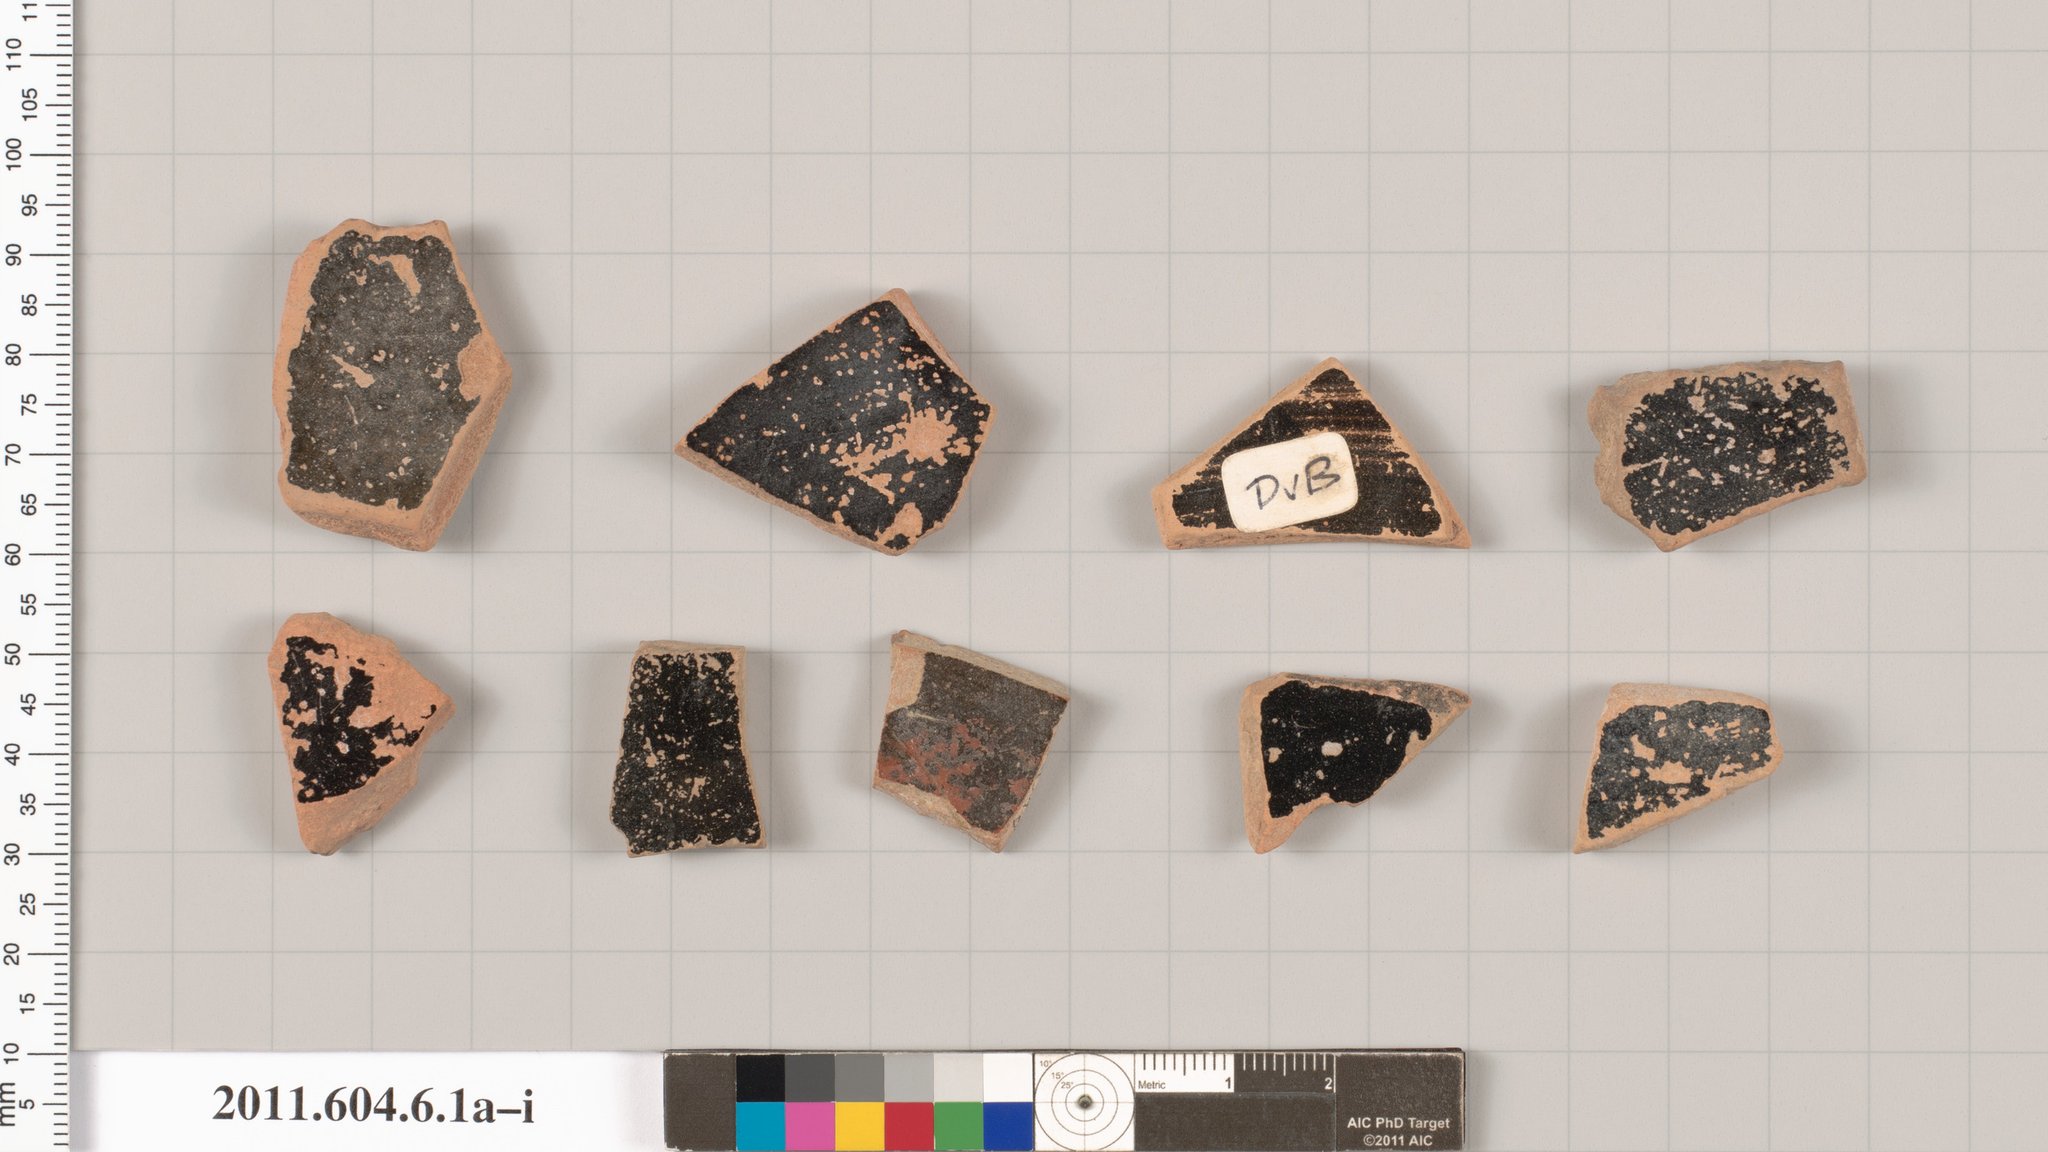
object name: undetermined open shape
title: Terracotta fragments of open shapes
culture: greek, attic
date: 600-401 BCE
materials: terracotta